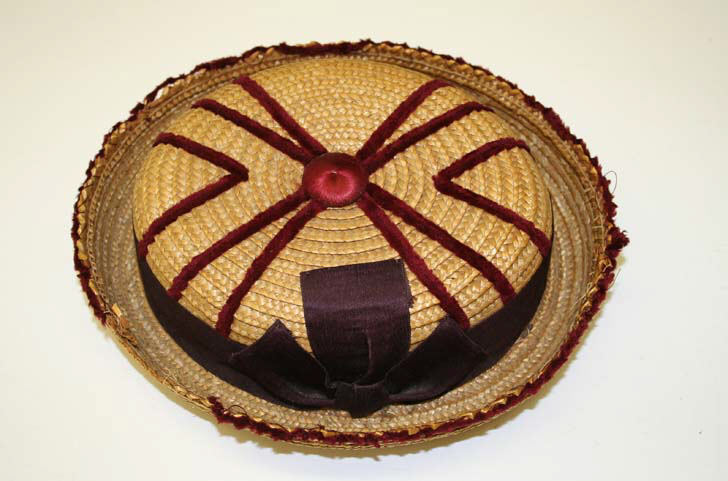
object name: hat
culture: american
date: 1866-1870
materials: silk, fiber